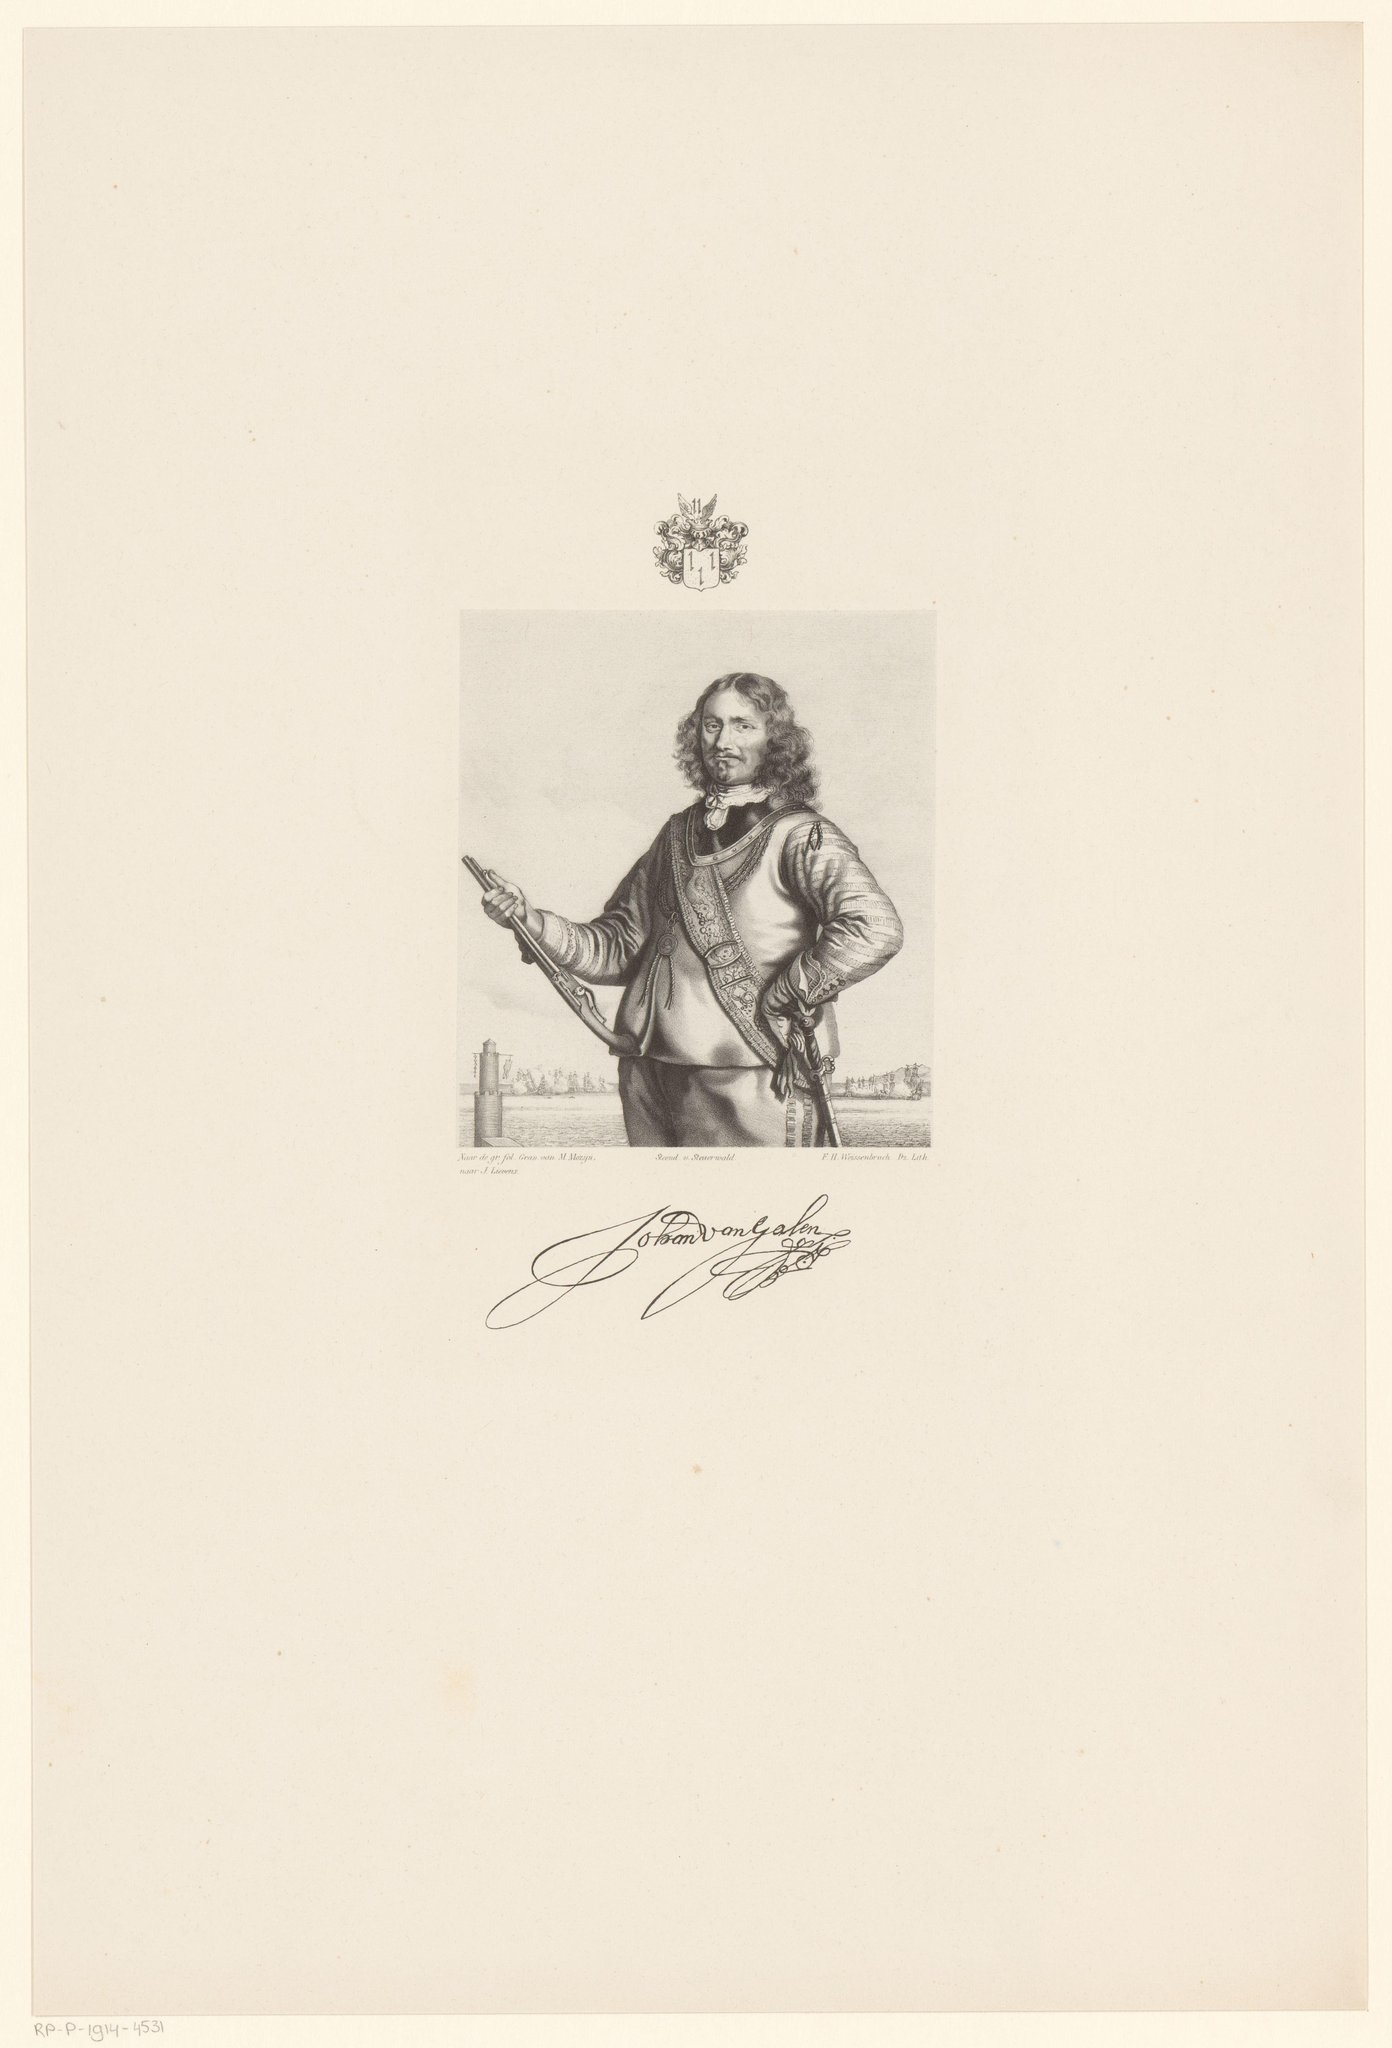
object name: book illustration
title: Portret van Jan van Galen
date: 1858-1862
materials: paper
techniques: lithograph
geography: the hague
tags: essen, historical persons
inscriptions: collector's mark: Lugt 2228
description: Prent uit: Jonge, J.C. de. Geschiedenis van het Nederlandsche zeewezen. Haarlem: Jonge, J.K.J. de, 1858-62.